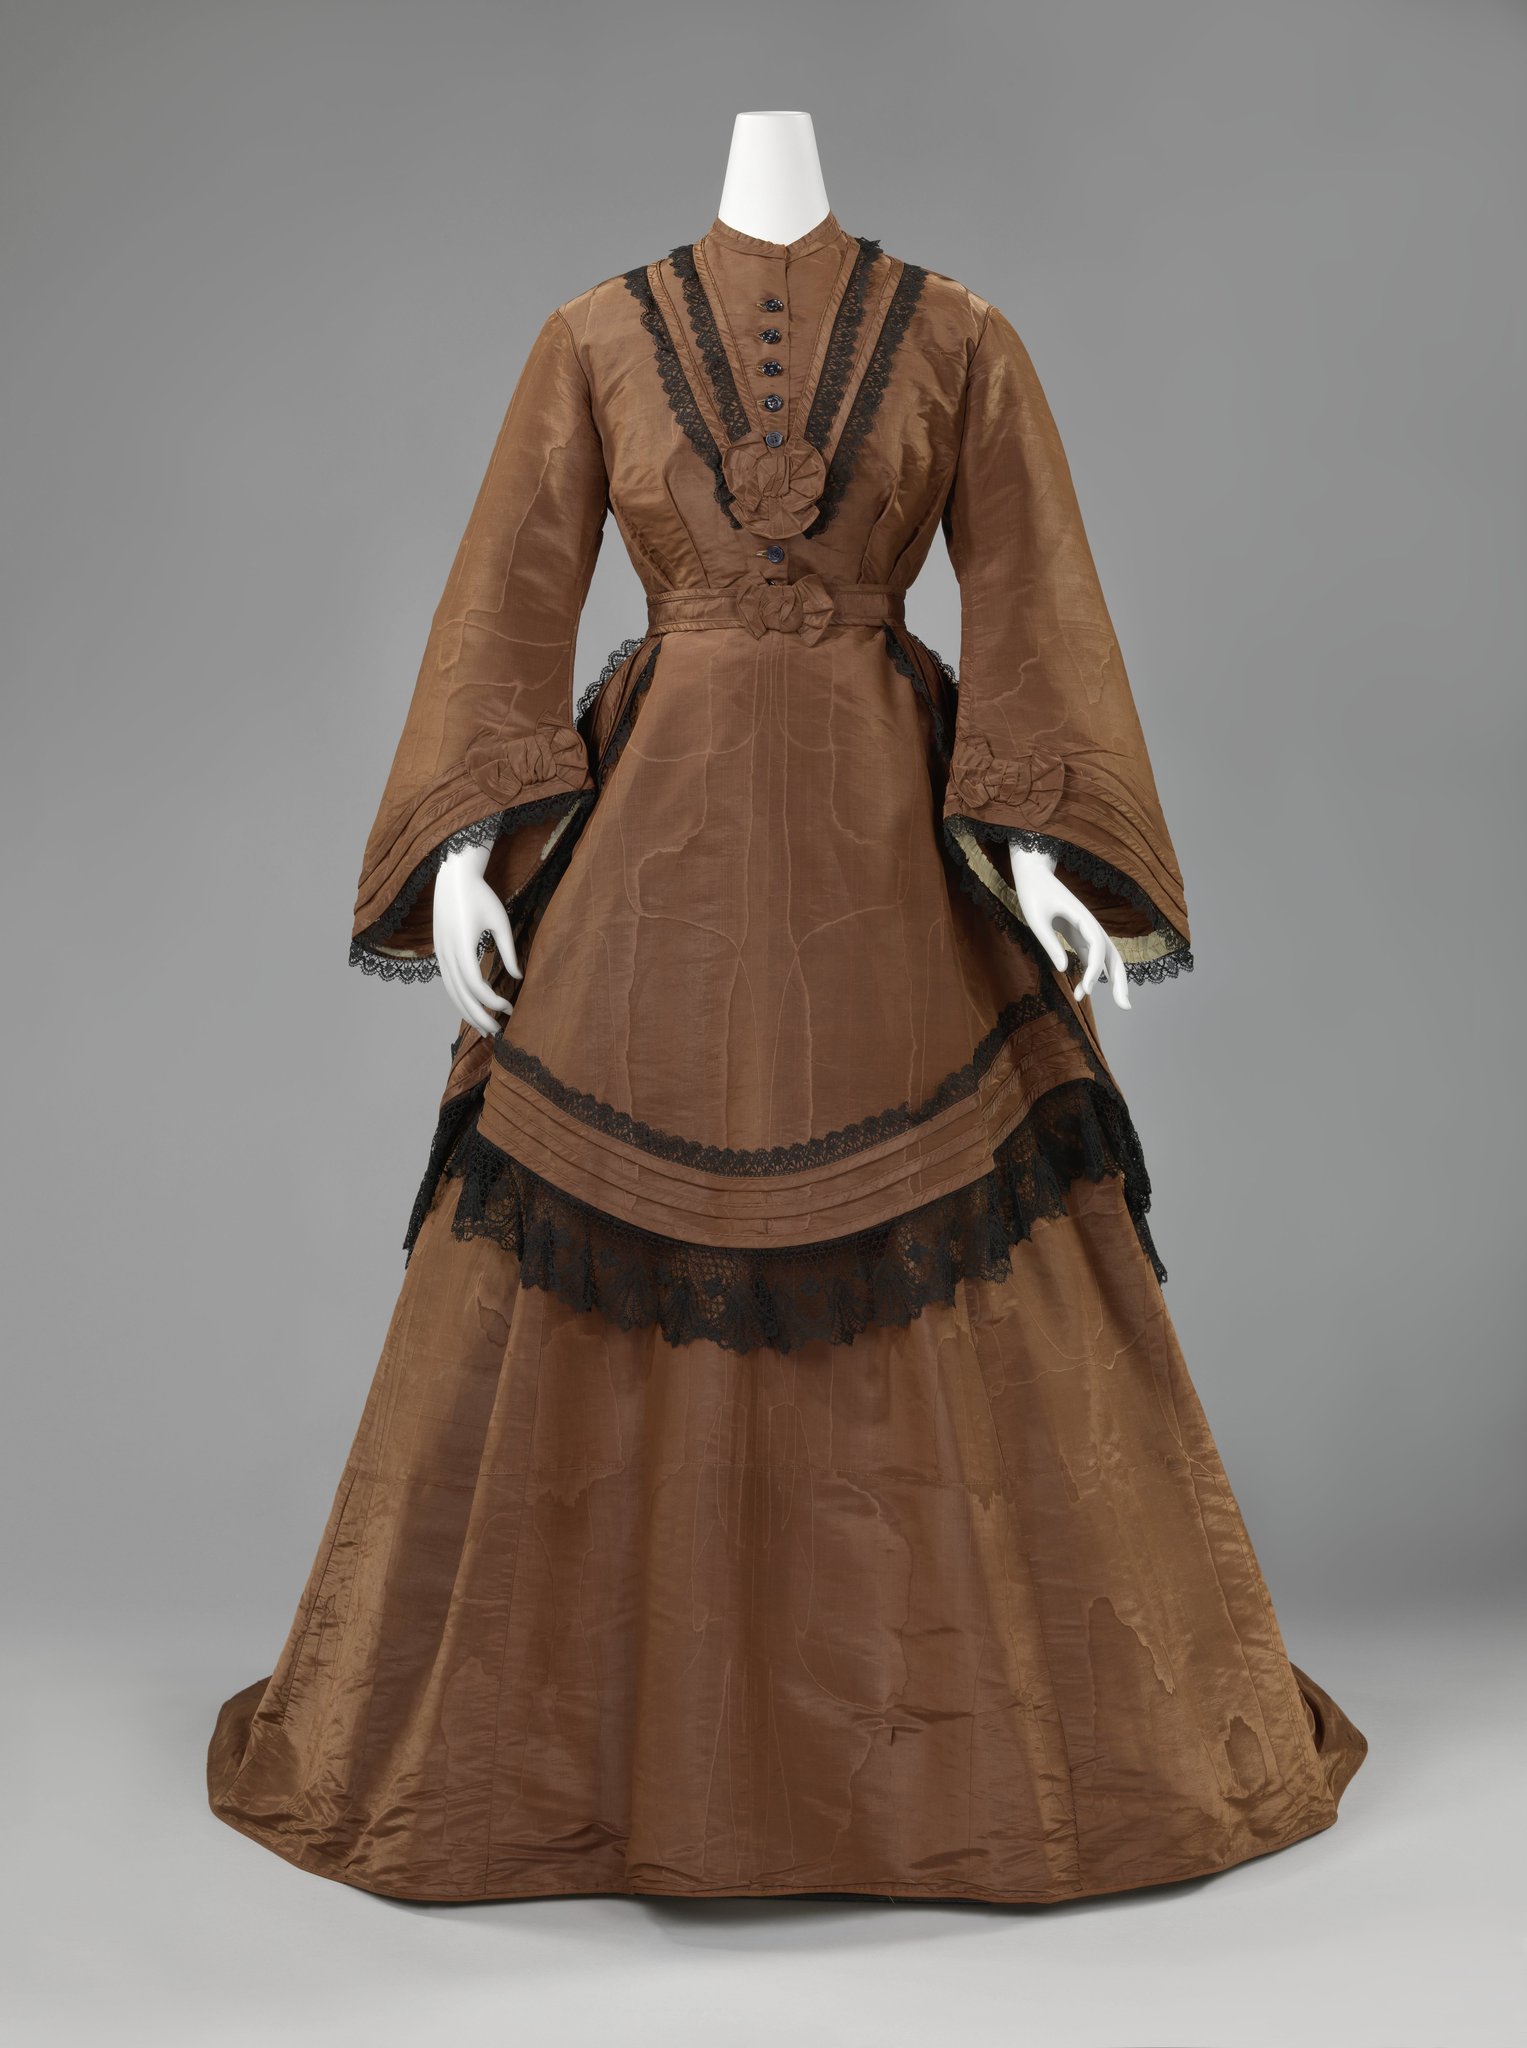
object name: womenswear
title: Day Dress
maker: Anonymous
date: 1868-1872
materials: silk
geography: netherlands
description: The fabric of this dress is moiré antique, which features large, irregular, undulating lines. This effect is achieved by folding ribbed fabric a particular way and subjecting it to heat and pressure to give it a watered appearance. The distorted ribs reflect light in different directions. The colours of the dress, black and brown, were all the rage in 1869.